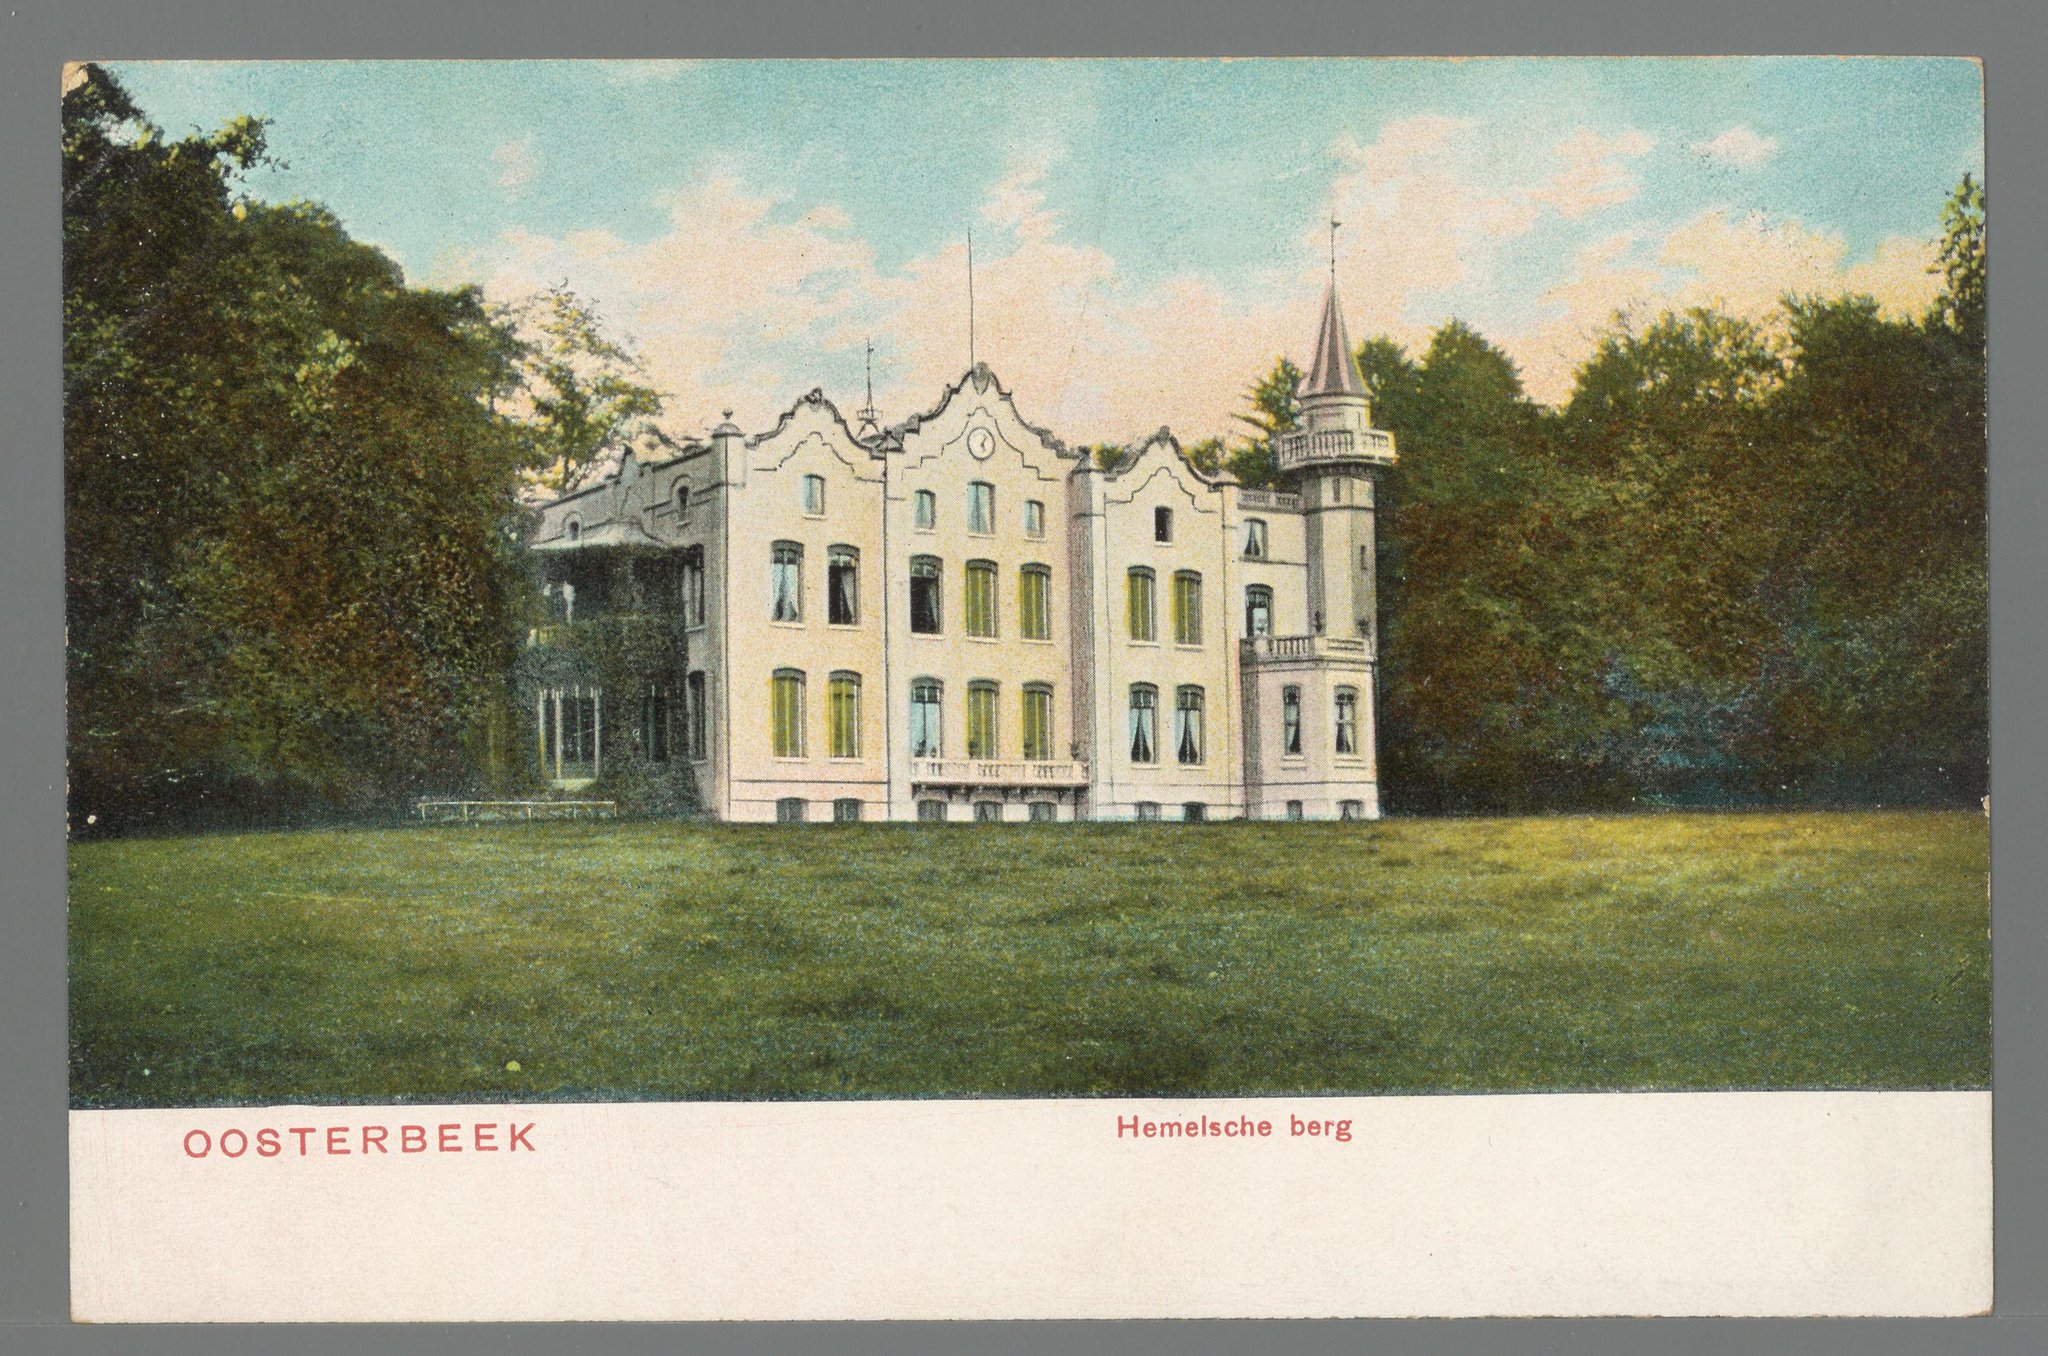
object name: ansichtkaart, prentbriefkaart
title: Oosterbeek. Hemelsche Berg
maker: Anonymous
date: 1905-1906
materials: cardboard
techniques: lithograph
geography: leipzig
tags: villa